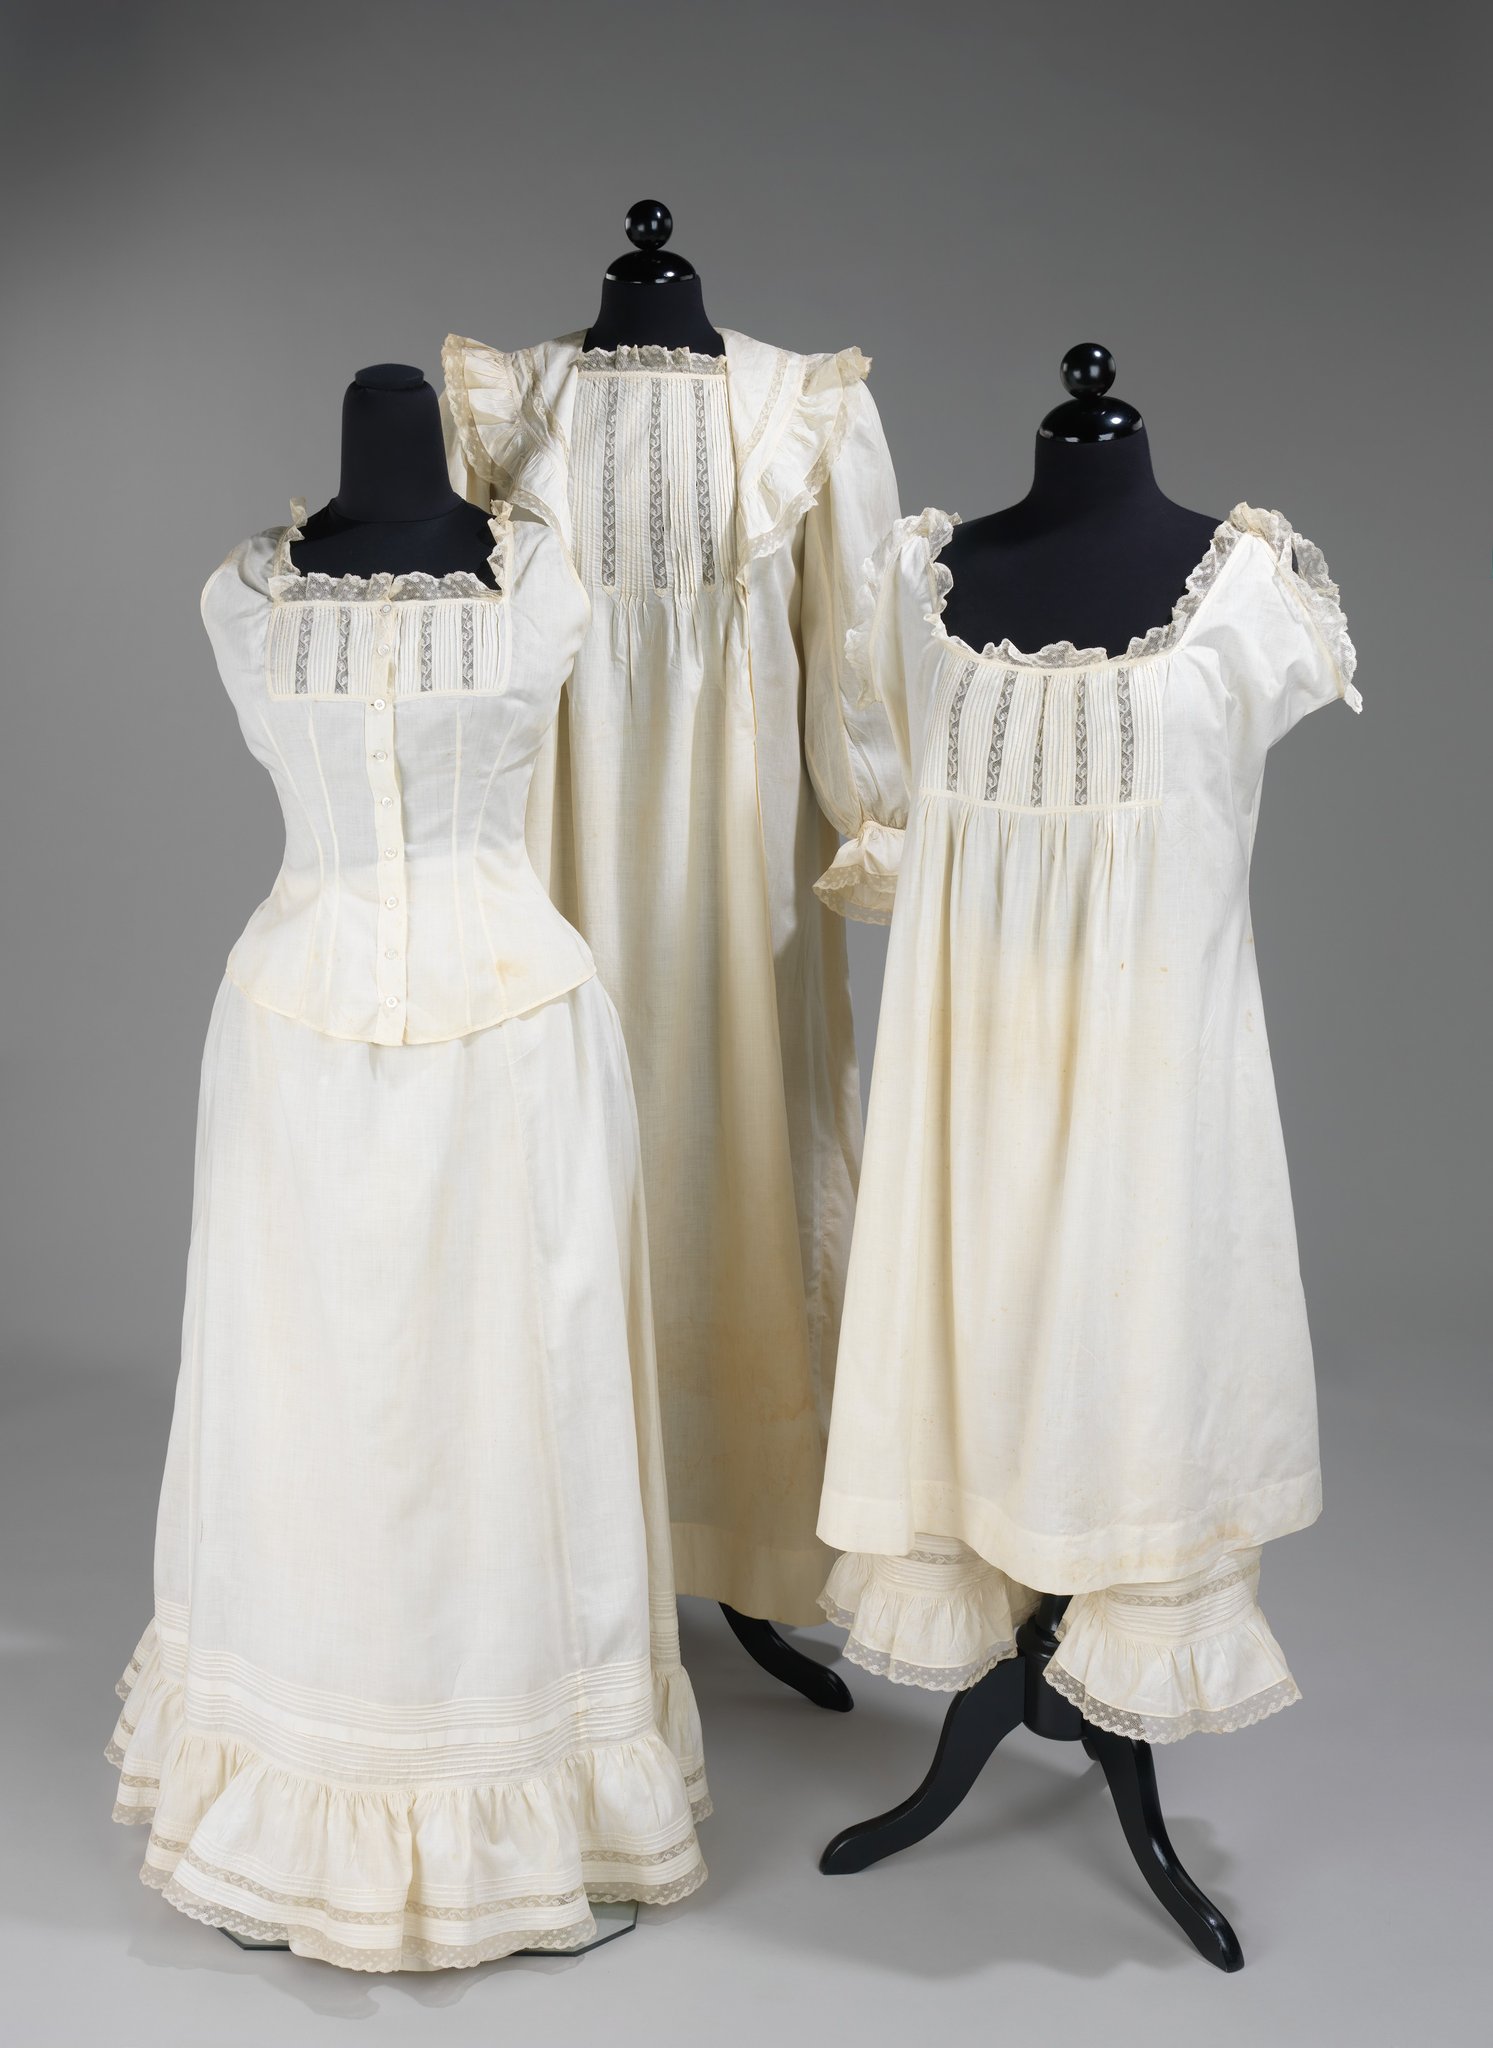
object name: lingerie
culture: american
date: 1898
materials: linen